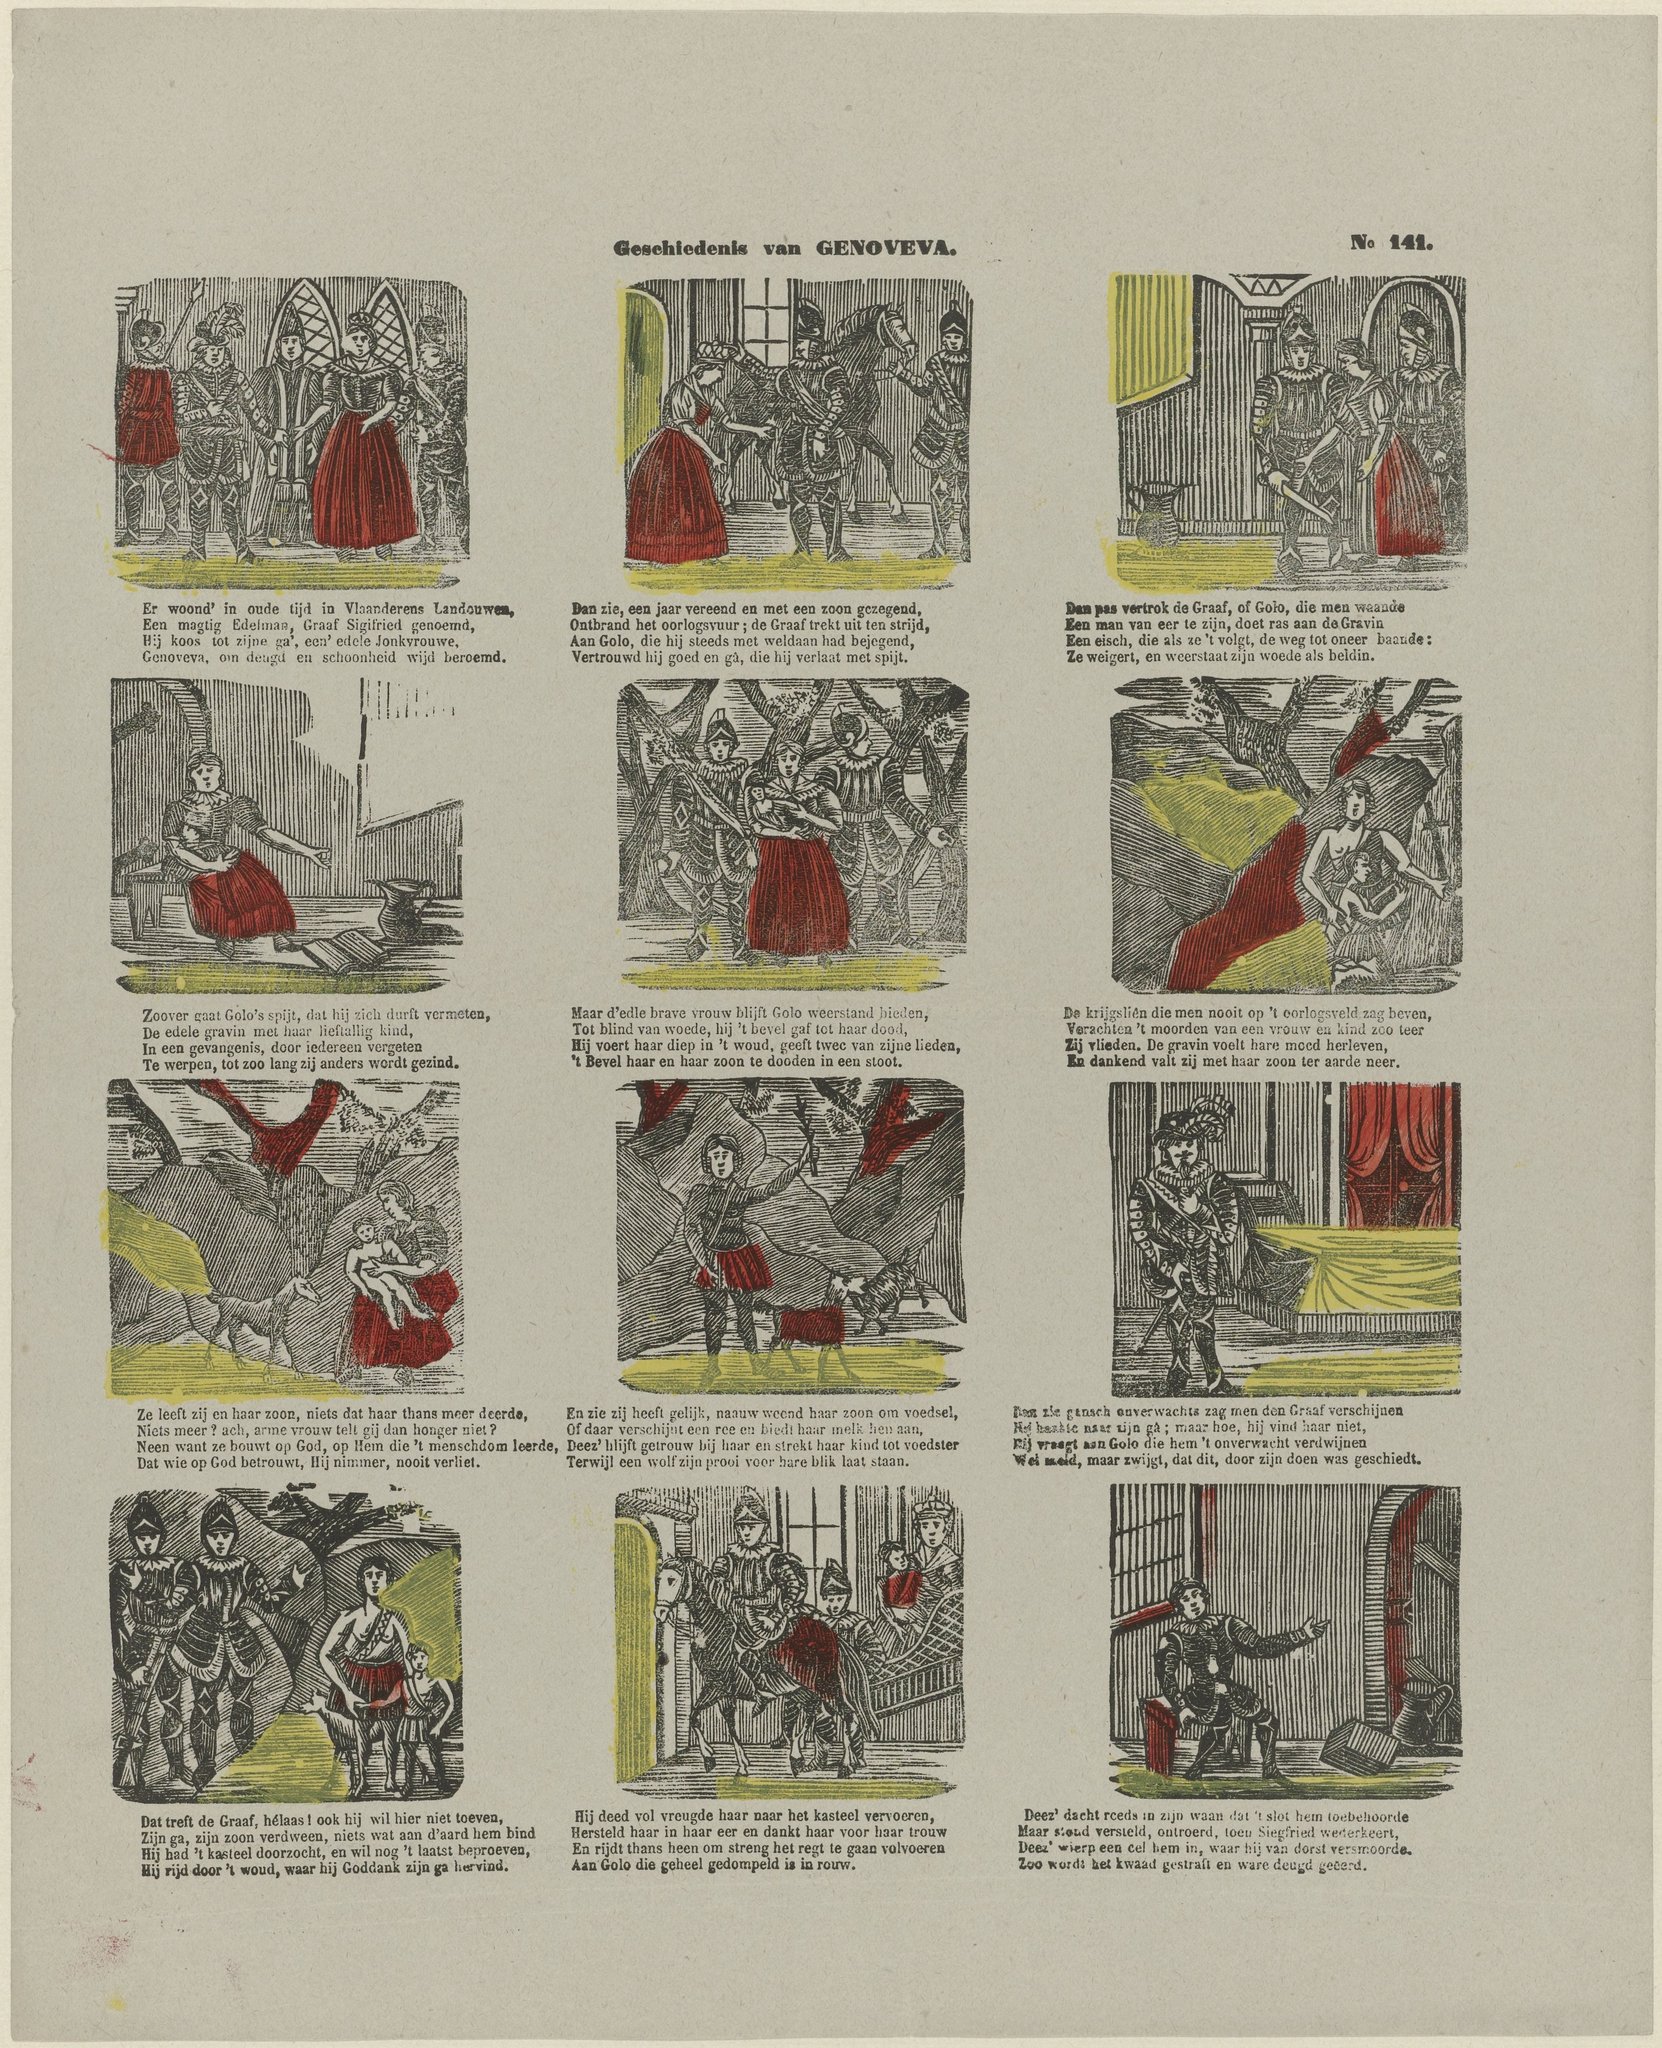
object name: print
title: Geschiedenis van Genoveva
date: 1827-1894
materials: paper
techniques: colour, letterpress printing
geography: schaarbeek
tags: genoveva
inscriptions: collector's mark: Lugt 2760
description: Blad met 12 voorstellingen over het leven van Genoveva van Brabant. Onder elke afbeelding een vierregelig vers. Genummerd rechtsboven: No 141.